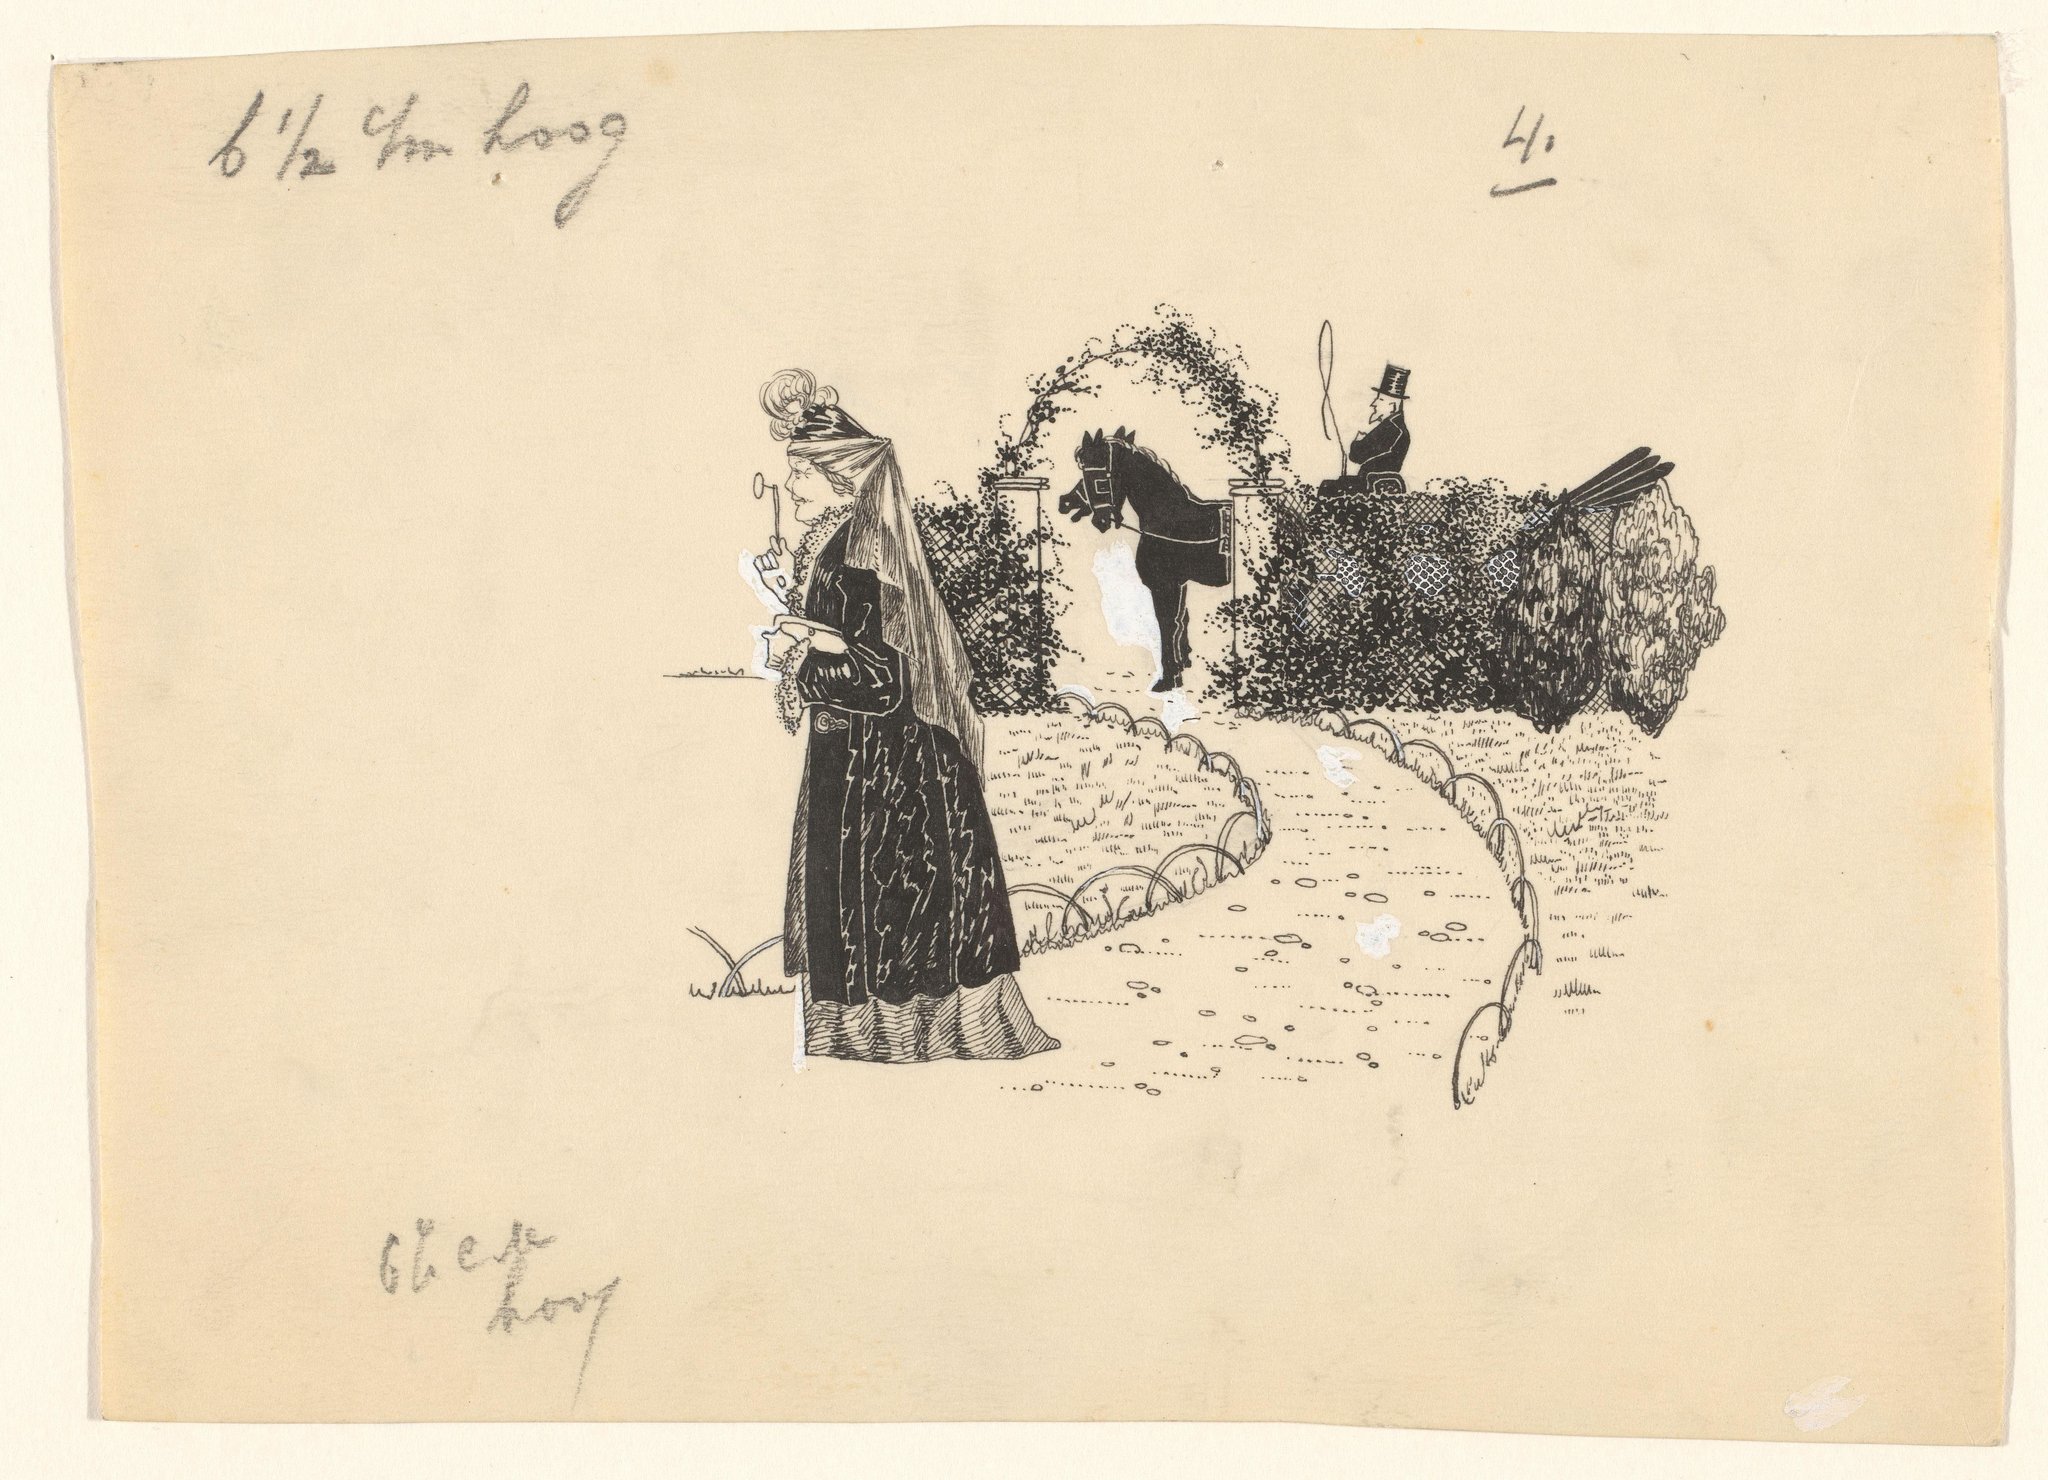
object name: drawing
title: Oude vrouw met lorgnet op een oprijlaan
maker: Anonymous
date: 1890-1930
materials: paint, ink, paper, pencil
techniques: brush, pen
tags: four-wheeled, animal-drawn vehicle, e.g.: cab, carriage, coach, old woman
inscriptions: collector's mark: Lugt 2228a, number: ‘4.’, :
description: Een oude vrouw gekleed in avondkleding staat met een lorgnet in de hand en een tas onder de arm op een oprijlaan. Aan het einde van de oprijlaan wacht een koets met koetsier.